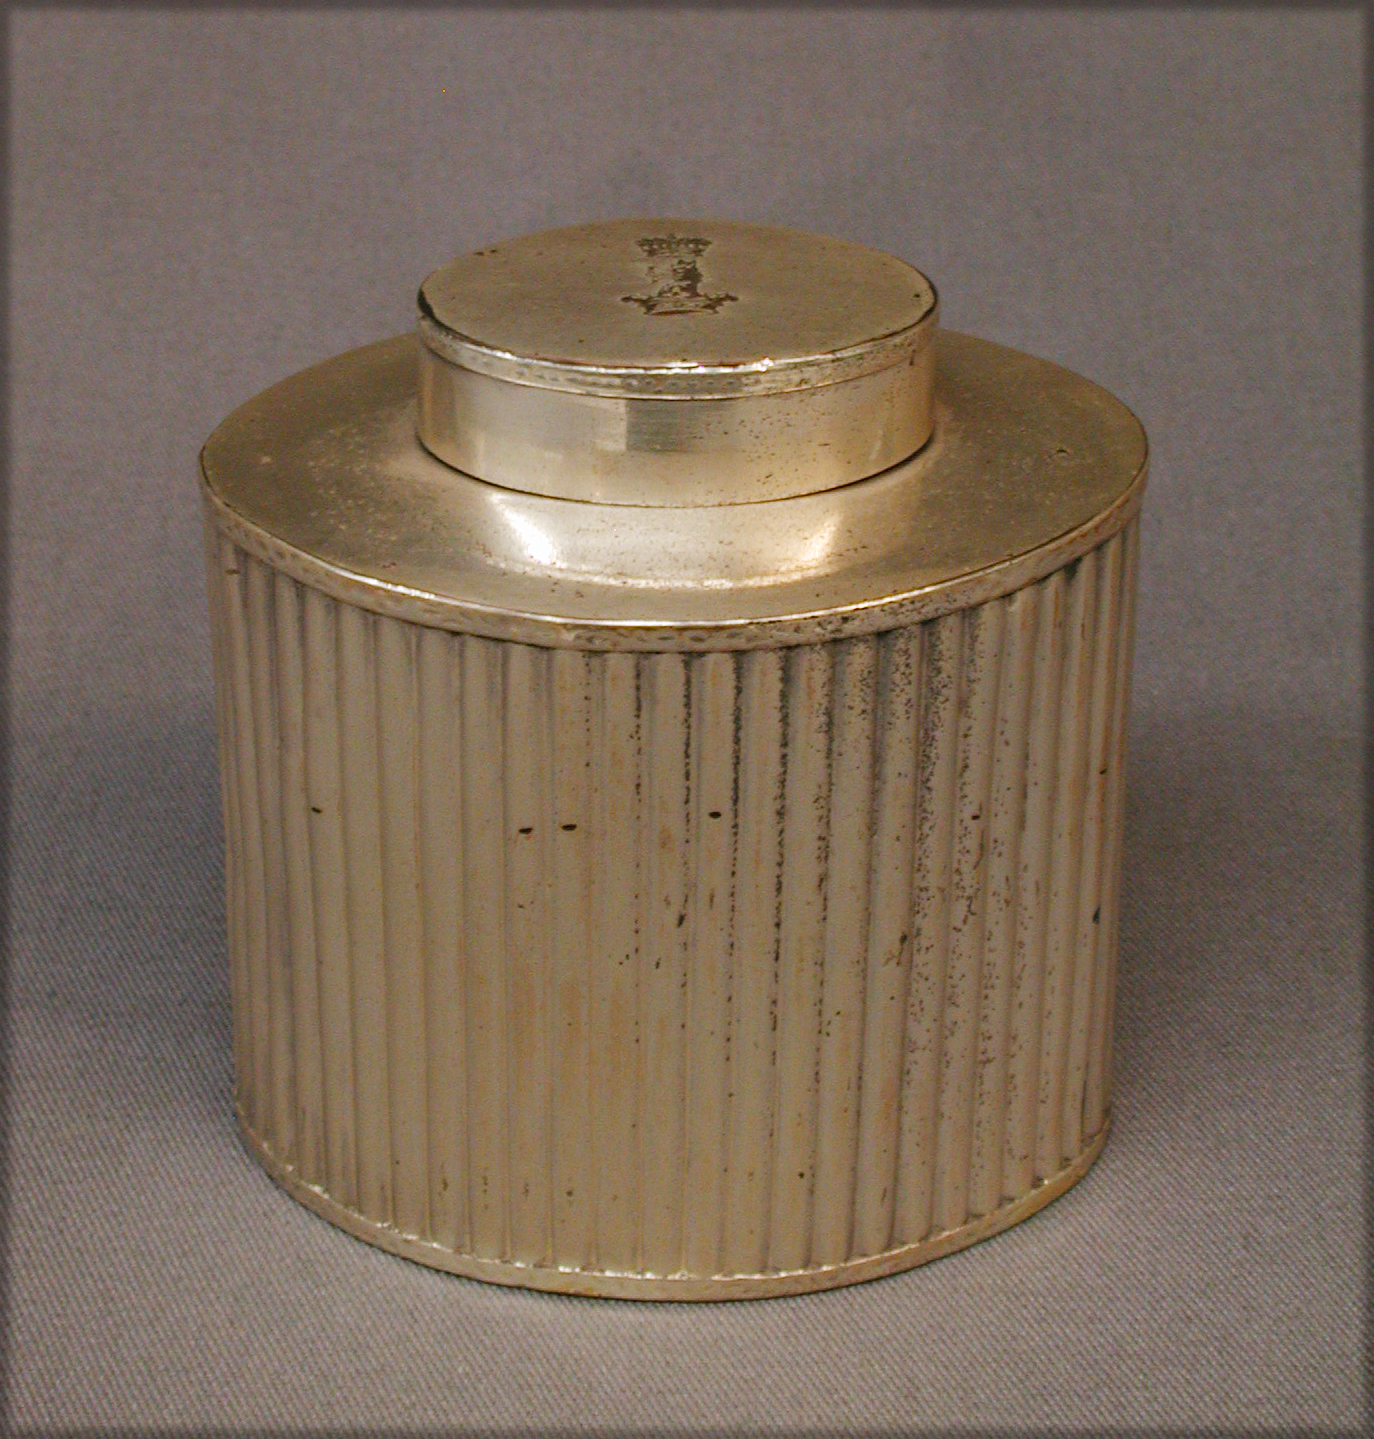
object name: tea caddy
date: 1790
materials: metal